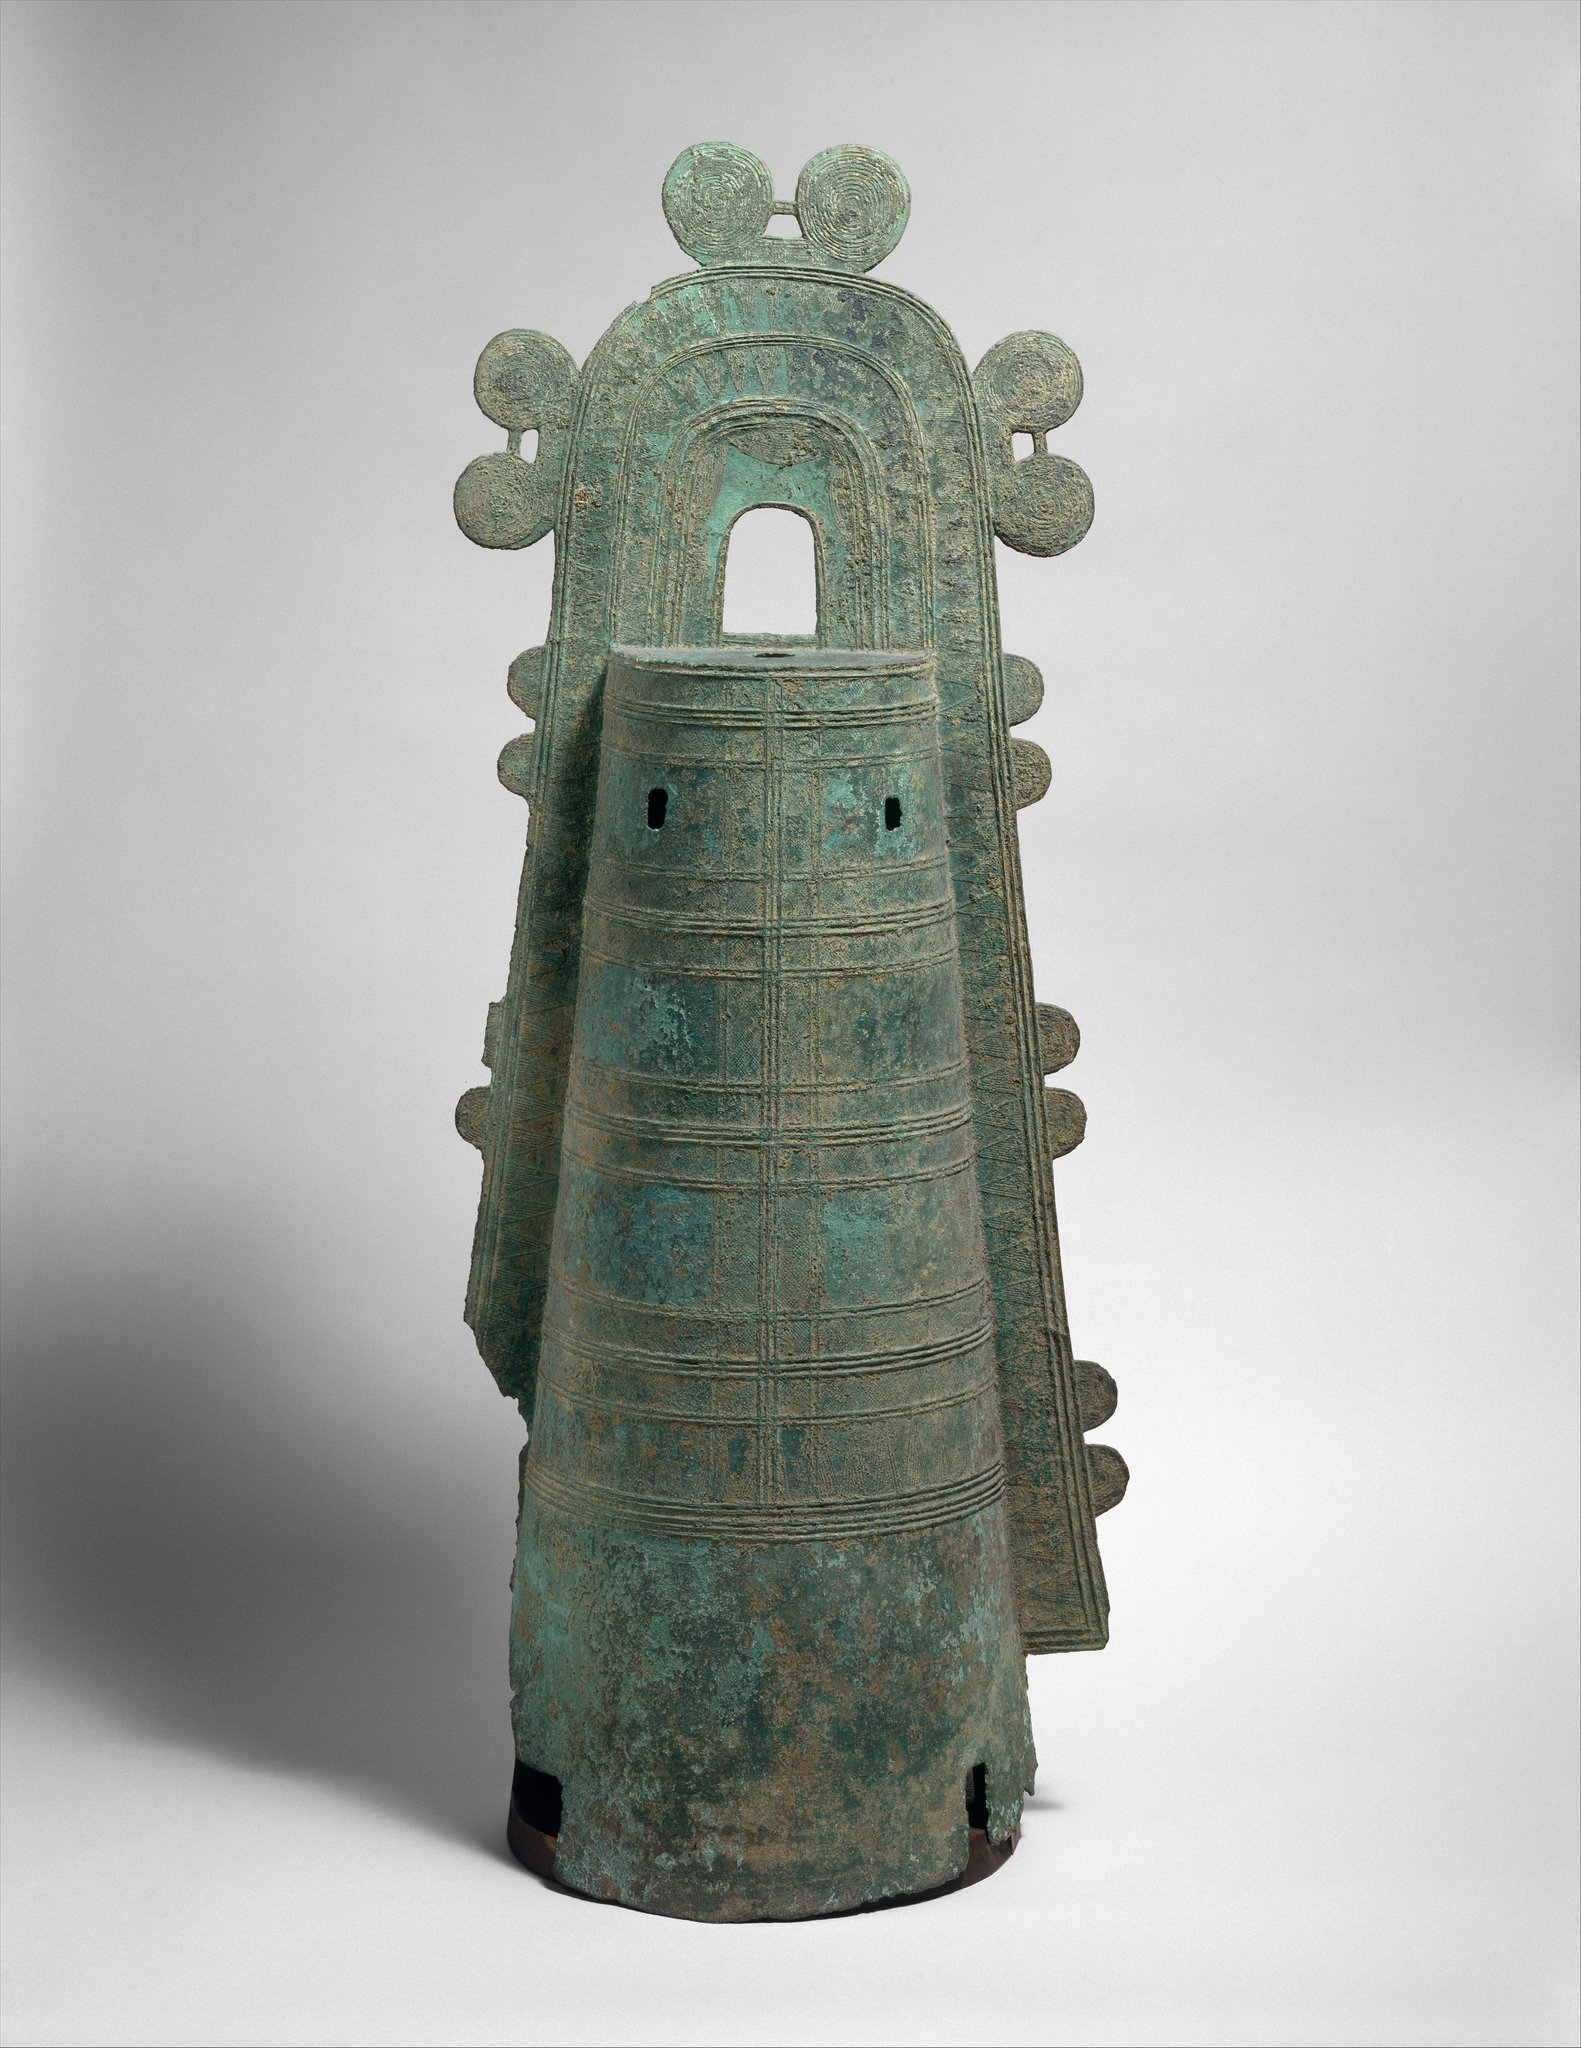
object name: bell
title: Dōtaku (Bronze Bell)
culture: japanese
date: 1-200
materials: bronze